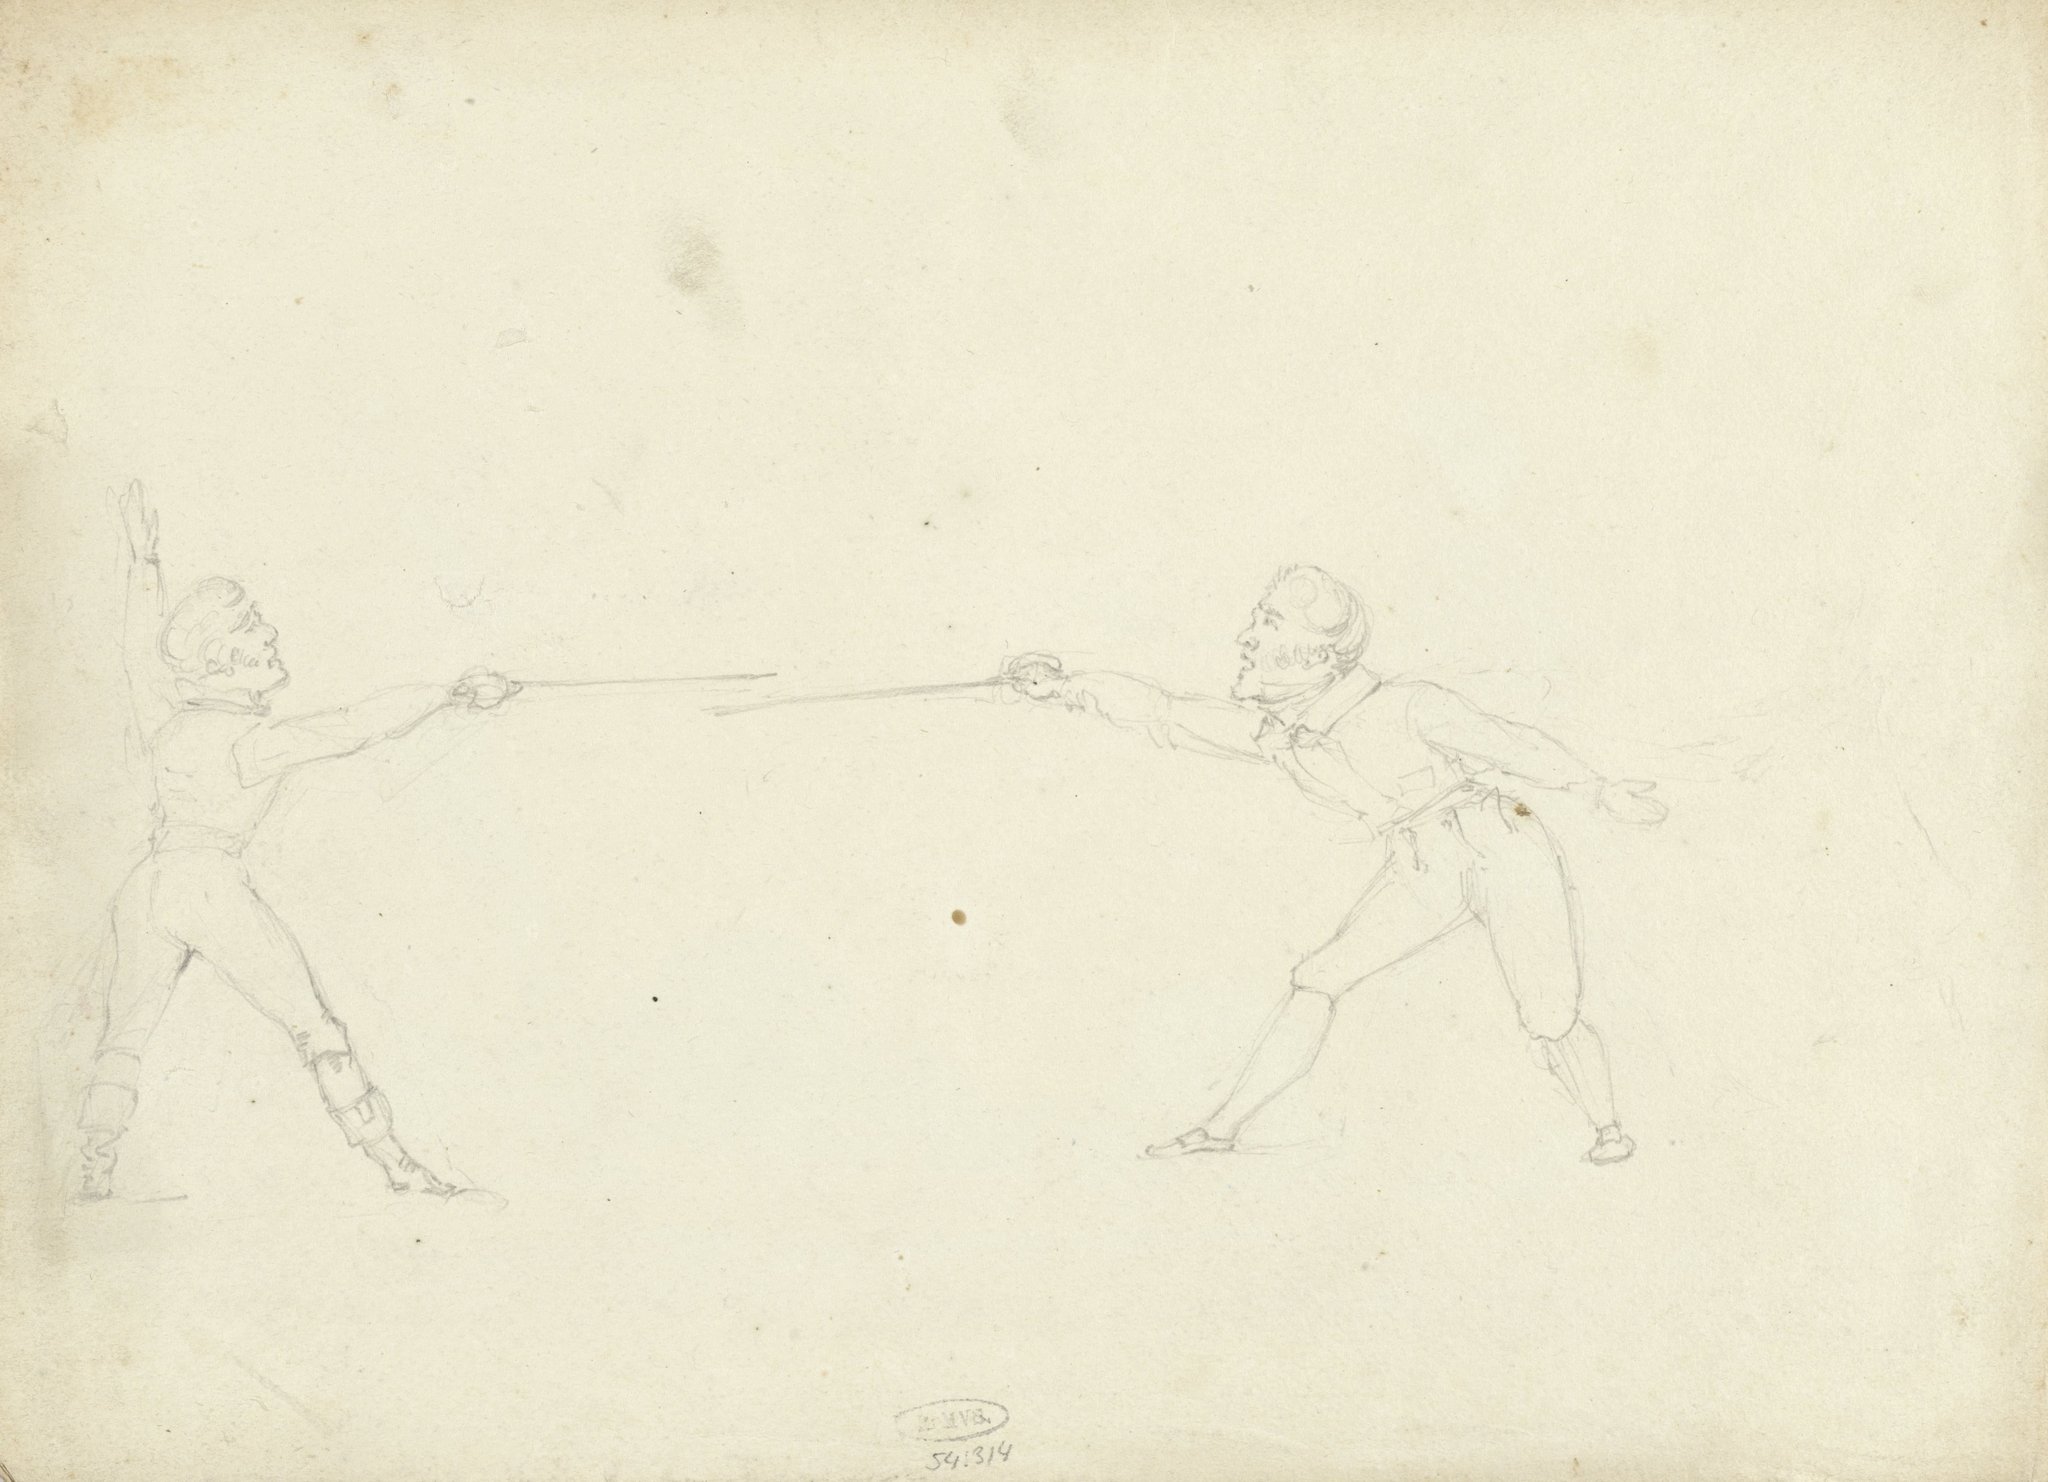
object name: drawing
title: Duellerende mannen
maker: pieter van loon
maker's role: draughtsman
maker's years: 1801-1873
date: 1811-1873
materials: paper, pencil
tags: duelling